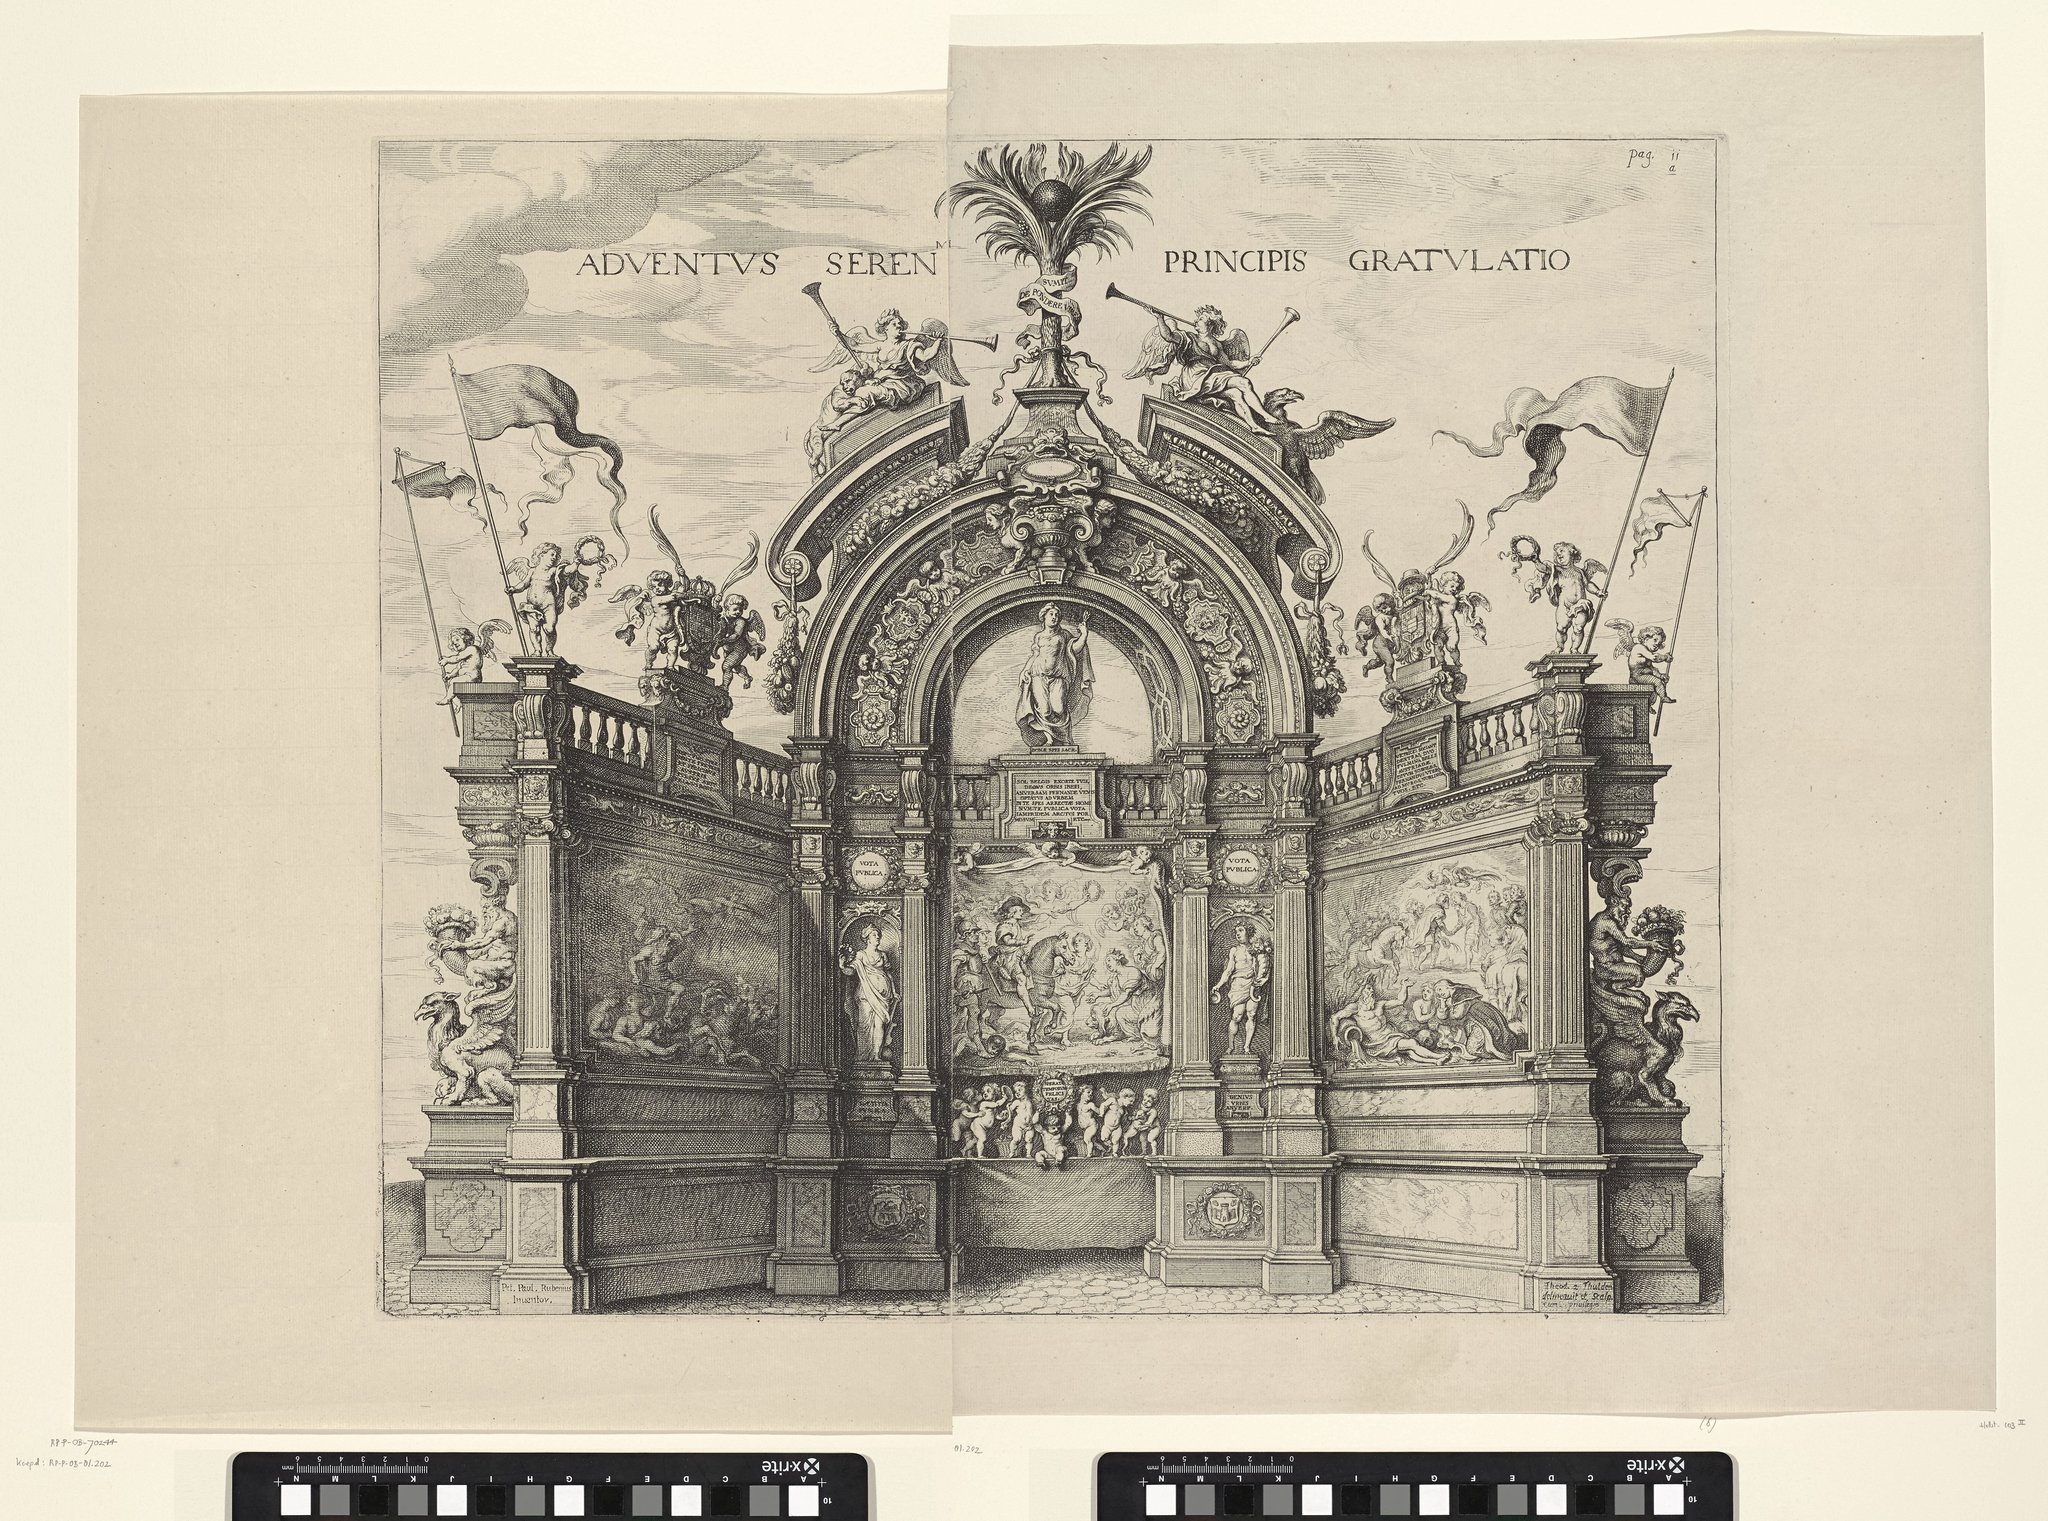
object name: print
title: Het welkomsttoneel; intocht van Ferdinand te Antwerpen in 1635 (nr. 6)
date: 1639-1641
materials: paper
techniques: engraving, etching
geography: southern netherlands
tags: brussels, landvoogd der zuidelijke nederlanden ferdinand van oostenrijk, triumphal entry and public reception, pageant, 'entrée solennelle', 'joyeuse entrée', antwerp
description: Oorspronkelijk gebruikt als illustratie in: C. Gevartius, Pompa introitus ... Ferdinandi Austriaci Hispaniarum Infantis ... a S.P.Q. Antverp, decreta et adornata, cum ... ad Norlingam parta victoria Antverpiam ... adventu suo bearet ... 1635 : arcus, pegmata iconesque a Pet. Paulo Rubenio ... inventas & delineatas inscriptionibus & elogiis ornabat, libroque commentario illustrabat, Theodoor van Thulden en Joannes Meursius, Antwerpen 1641, pl. 6. Dit object is omwille van een betere presentatie virtueel samengevoegd, maar bestaat fysiek uit losse onderdelen.